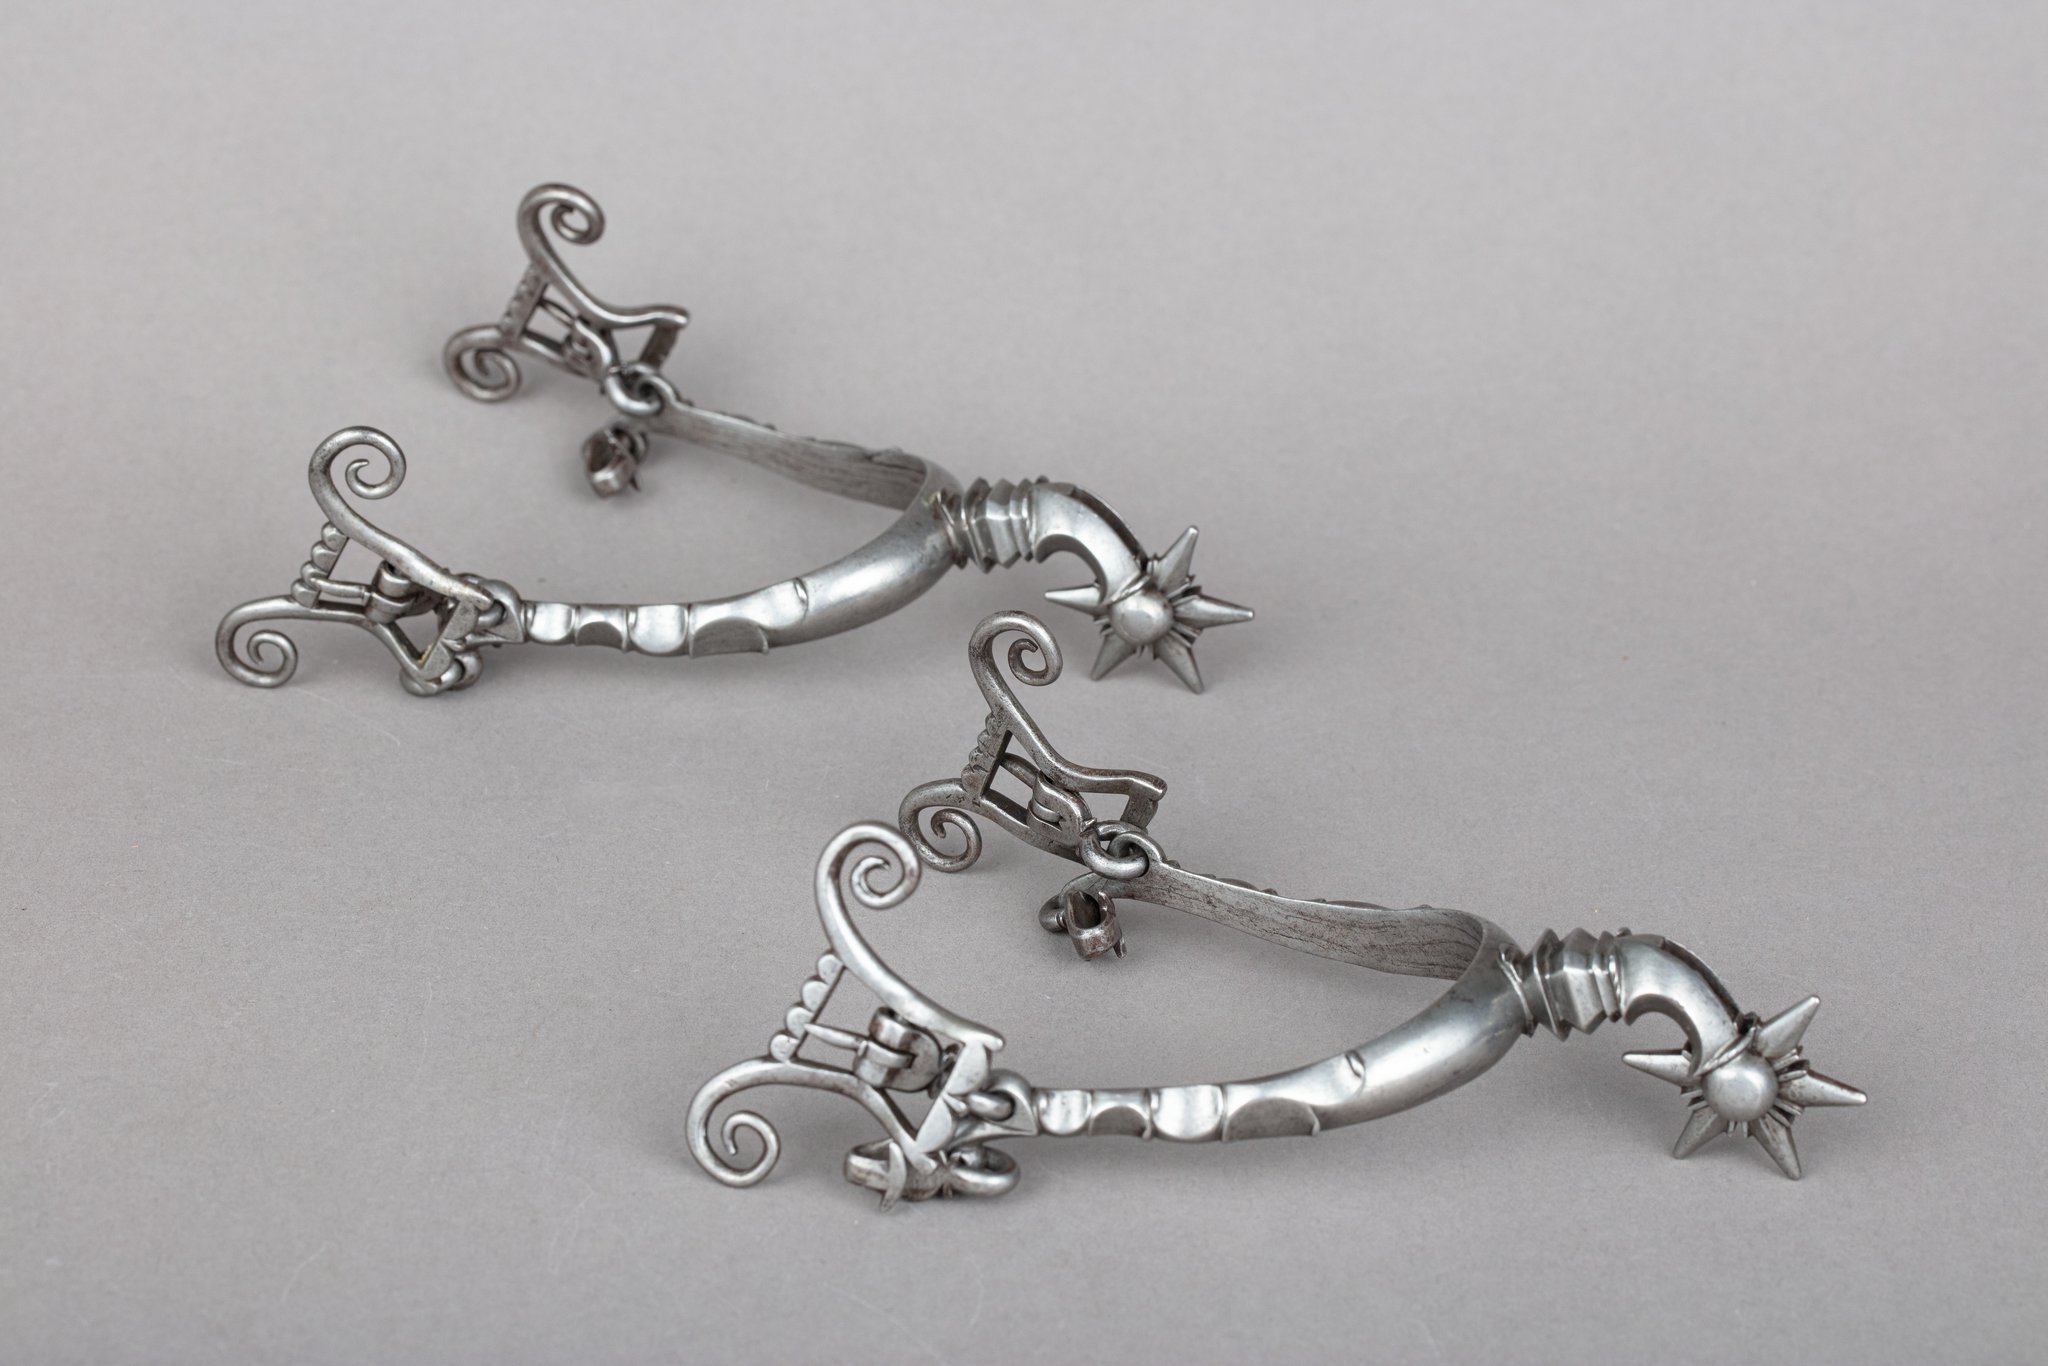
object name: spur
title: Pair of Rowel Spurs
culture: german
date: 1651-1700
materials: metal alloy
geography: germany